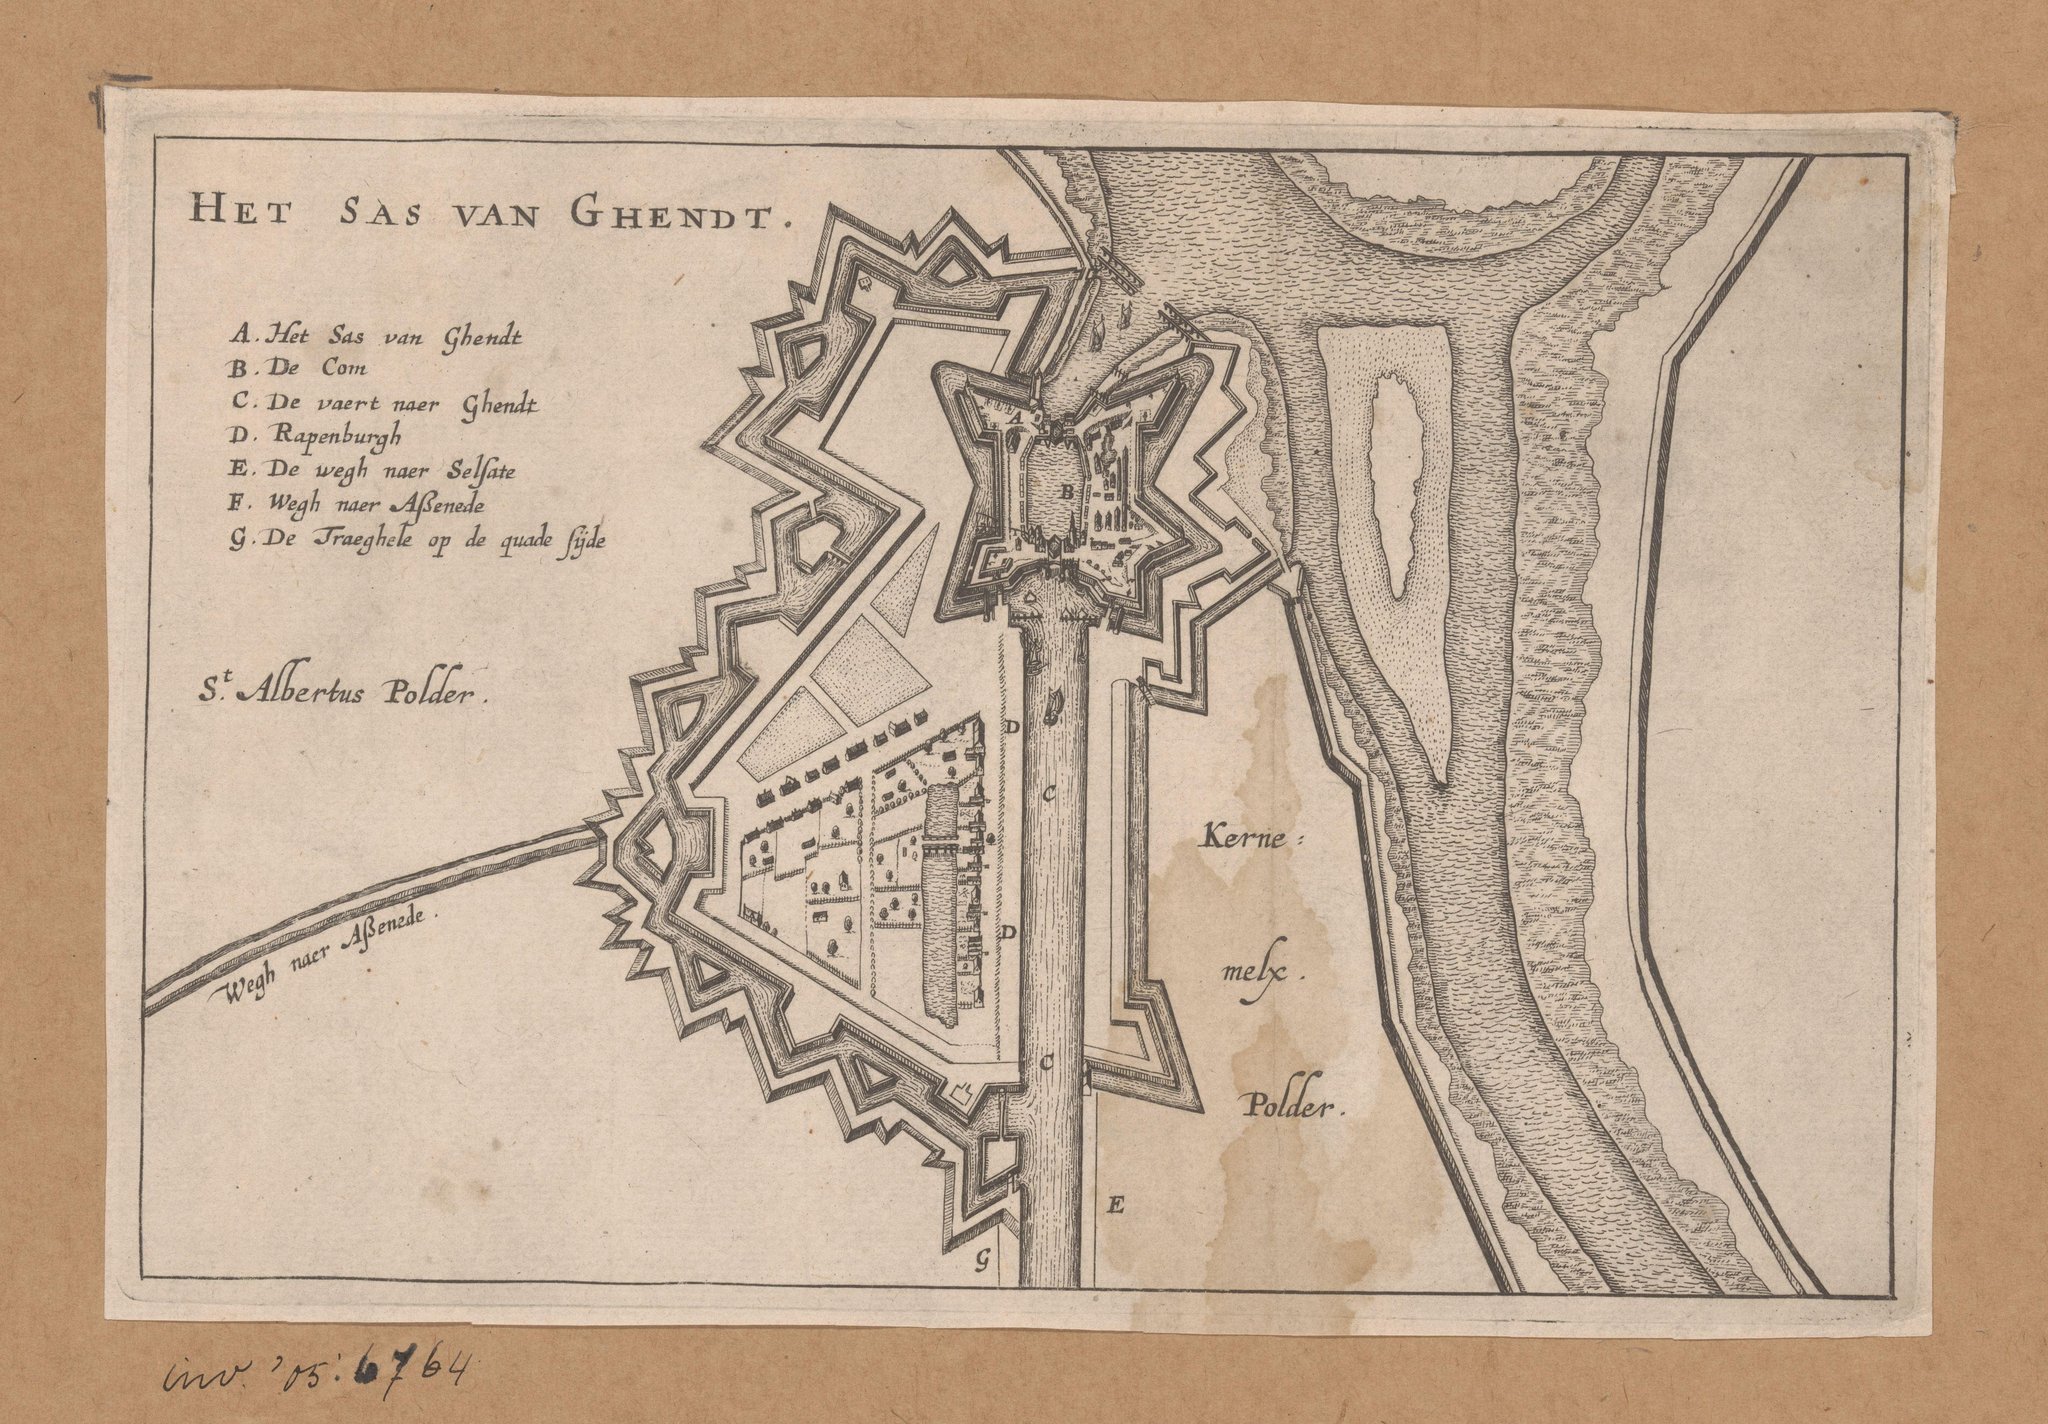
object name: area plan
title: Vestingplattegrond van Sas van Gent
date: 1649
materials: paper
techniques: etching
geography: amsterdam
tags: fortified city, maps of cities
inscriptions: collector's mark: Lugt 2228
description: Prent uit: Novum ac magnum theatrum urbium Belgicæ (...). Amsterdam: Johannes Willemszoon Blaeu, 1649.